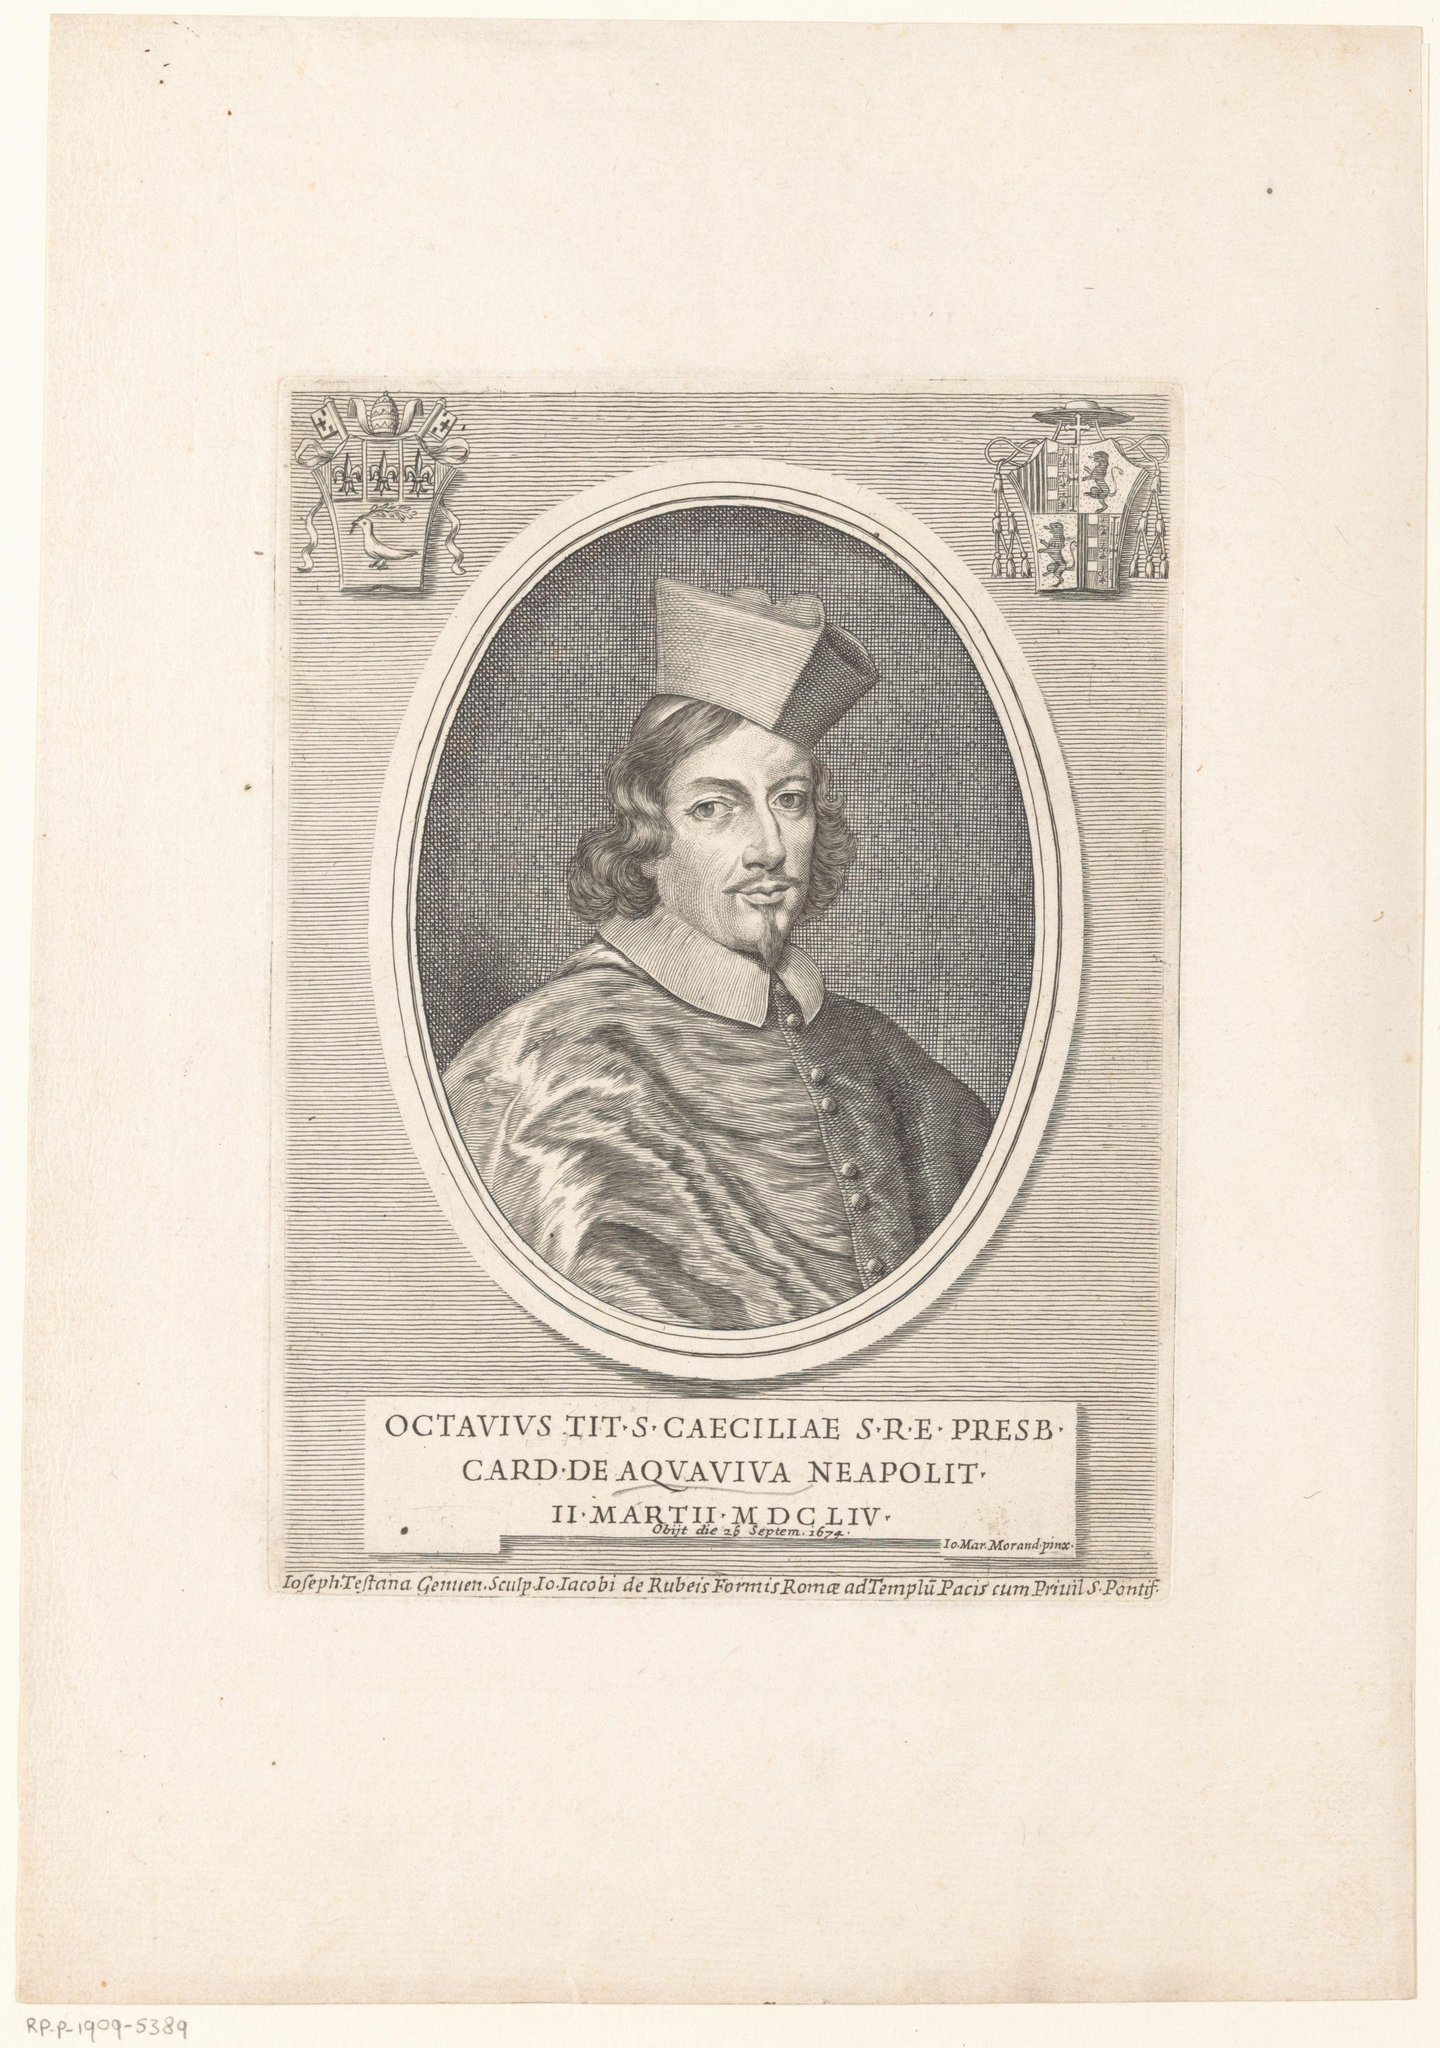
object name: print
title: Effigies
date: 1658-1679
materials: paper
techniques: engraving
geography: italy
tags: naples, rome, cardinal, historical persons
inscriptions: collector's mark: Lugt 2228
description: Prent uit een reeks van onbekende omvang met portretten van kardinalen. De prenten werden vanaf 1657 vervaardigd in opdracht van uitgever Giovanni Giacomo de’ Rossi, waarna de productie werd voortgezet onder leiding van zijn opvolgers Domenico de’ Rossi en Lorenzo Filippo de’ Rossi, en ten slotte onder leiding van de Calcographia R.C.A.